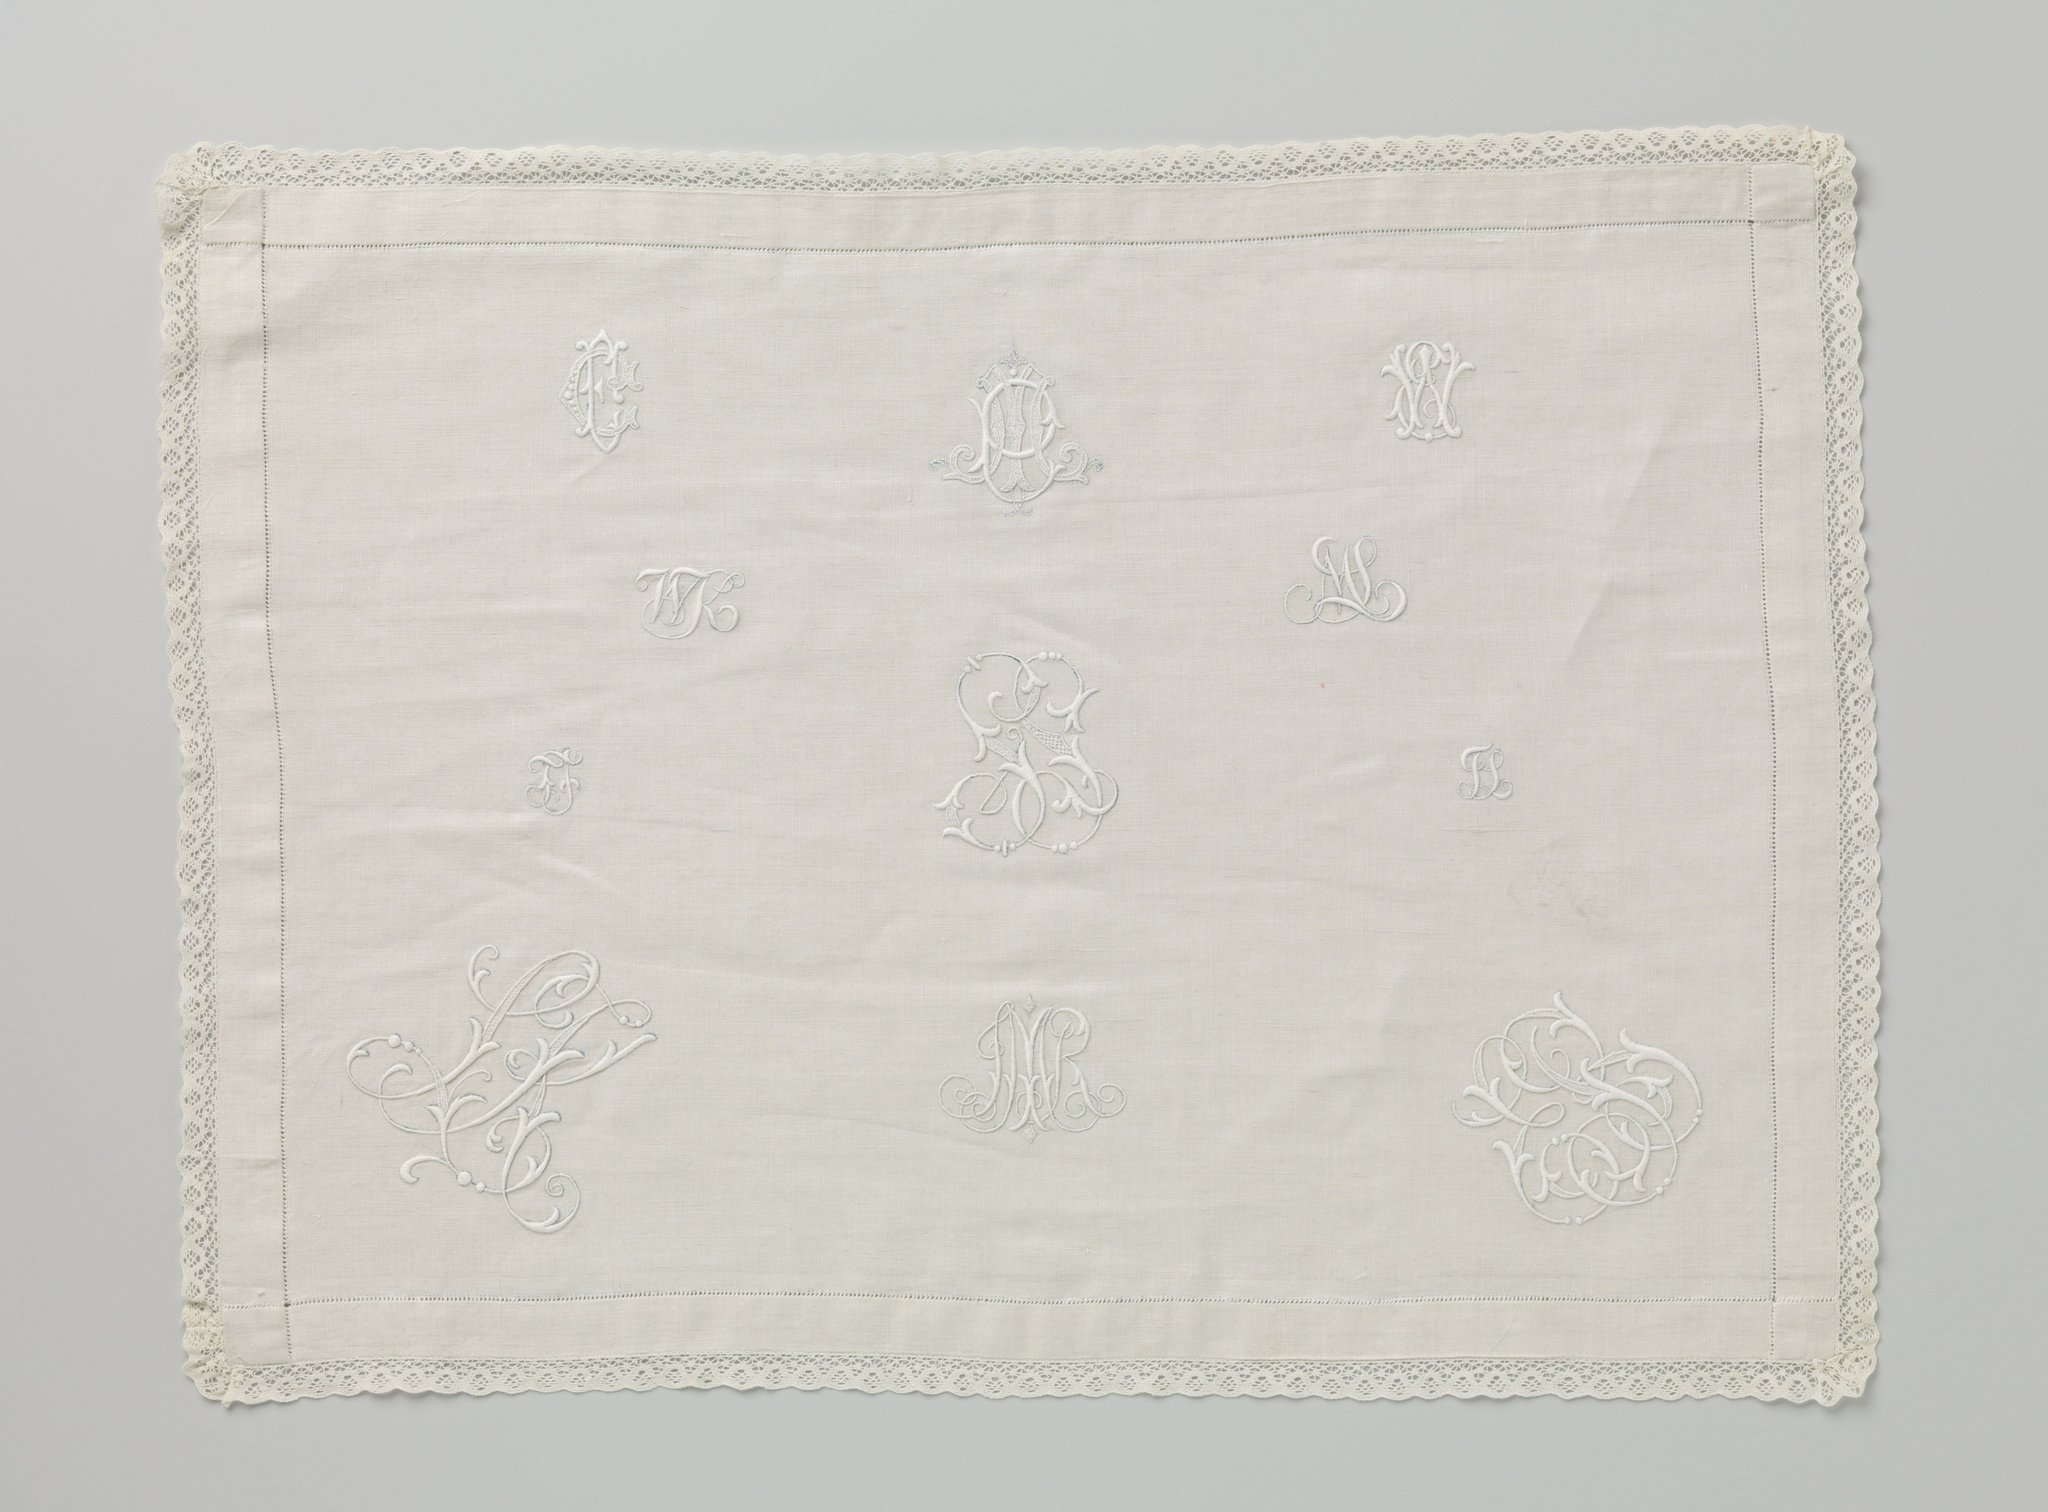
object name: merkdoek, merklap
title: Borduurlap van linnen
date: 1880-1905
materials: linen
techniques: embroidered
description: Borduurlap van wit garen op linnen. Het borduurwerk heeft monogrammen, Frans borduurwerk en in het midden de initialen JMR.